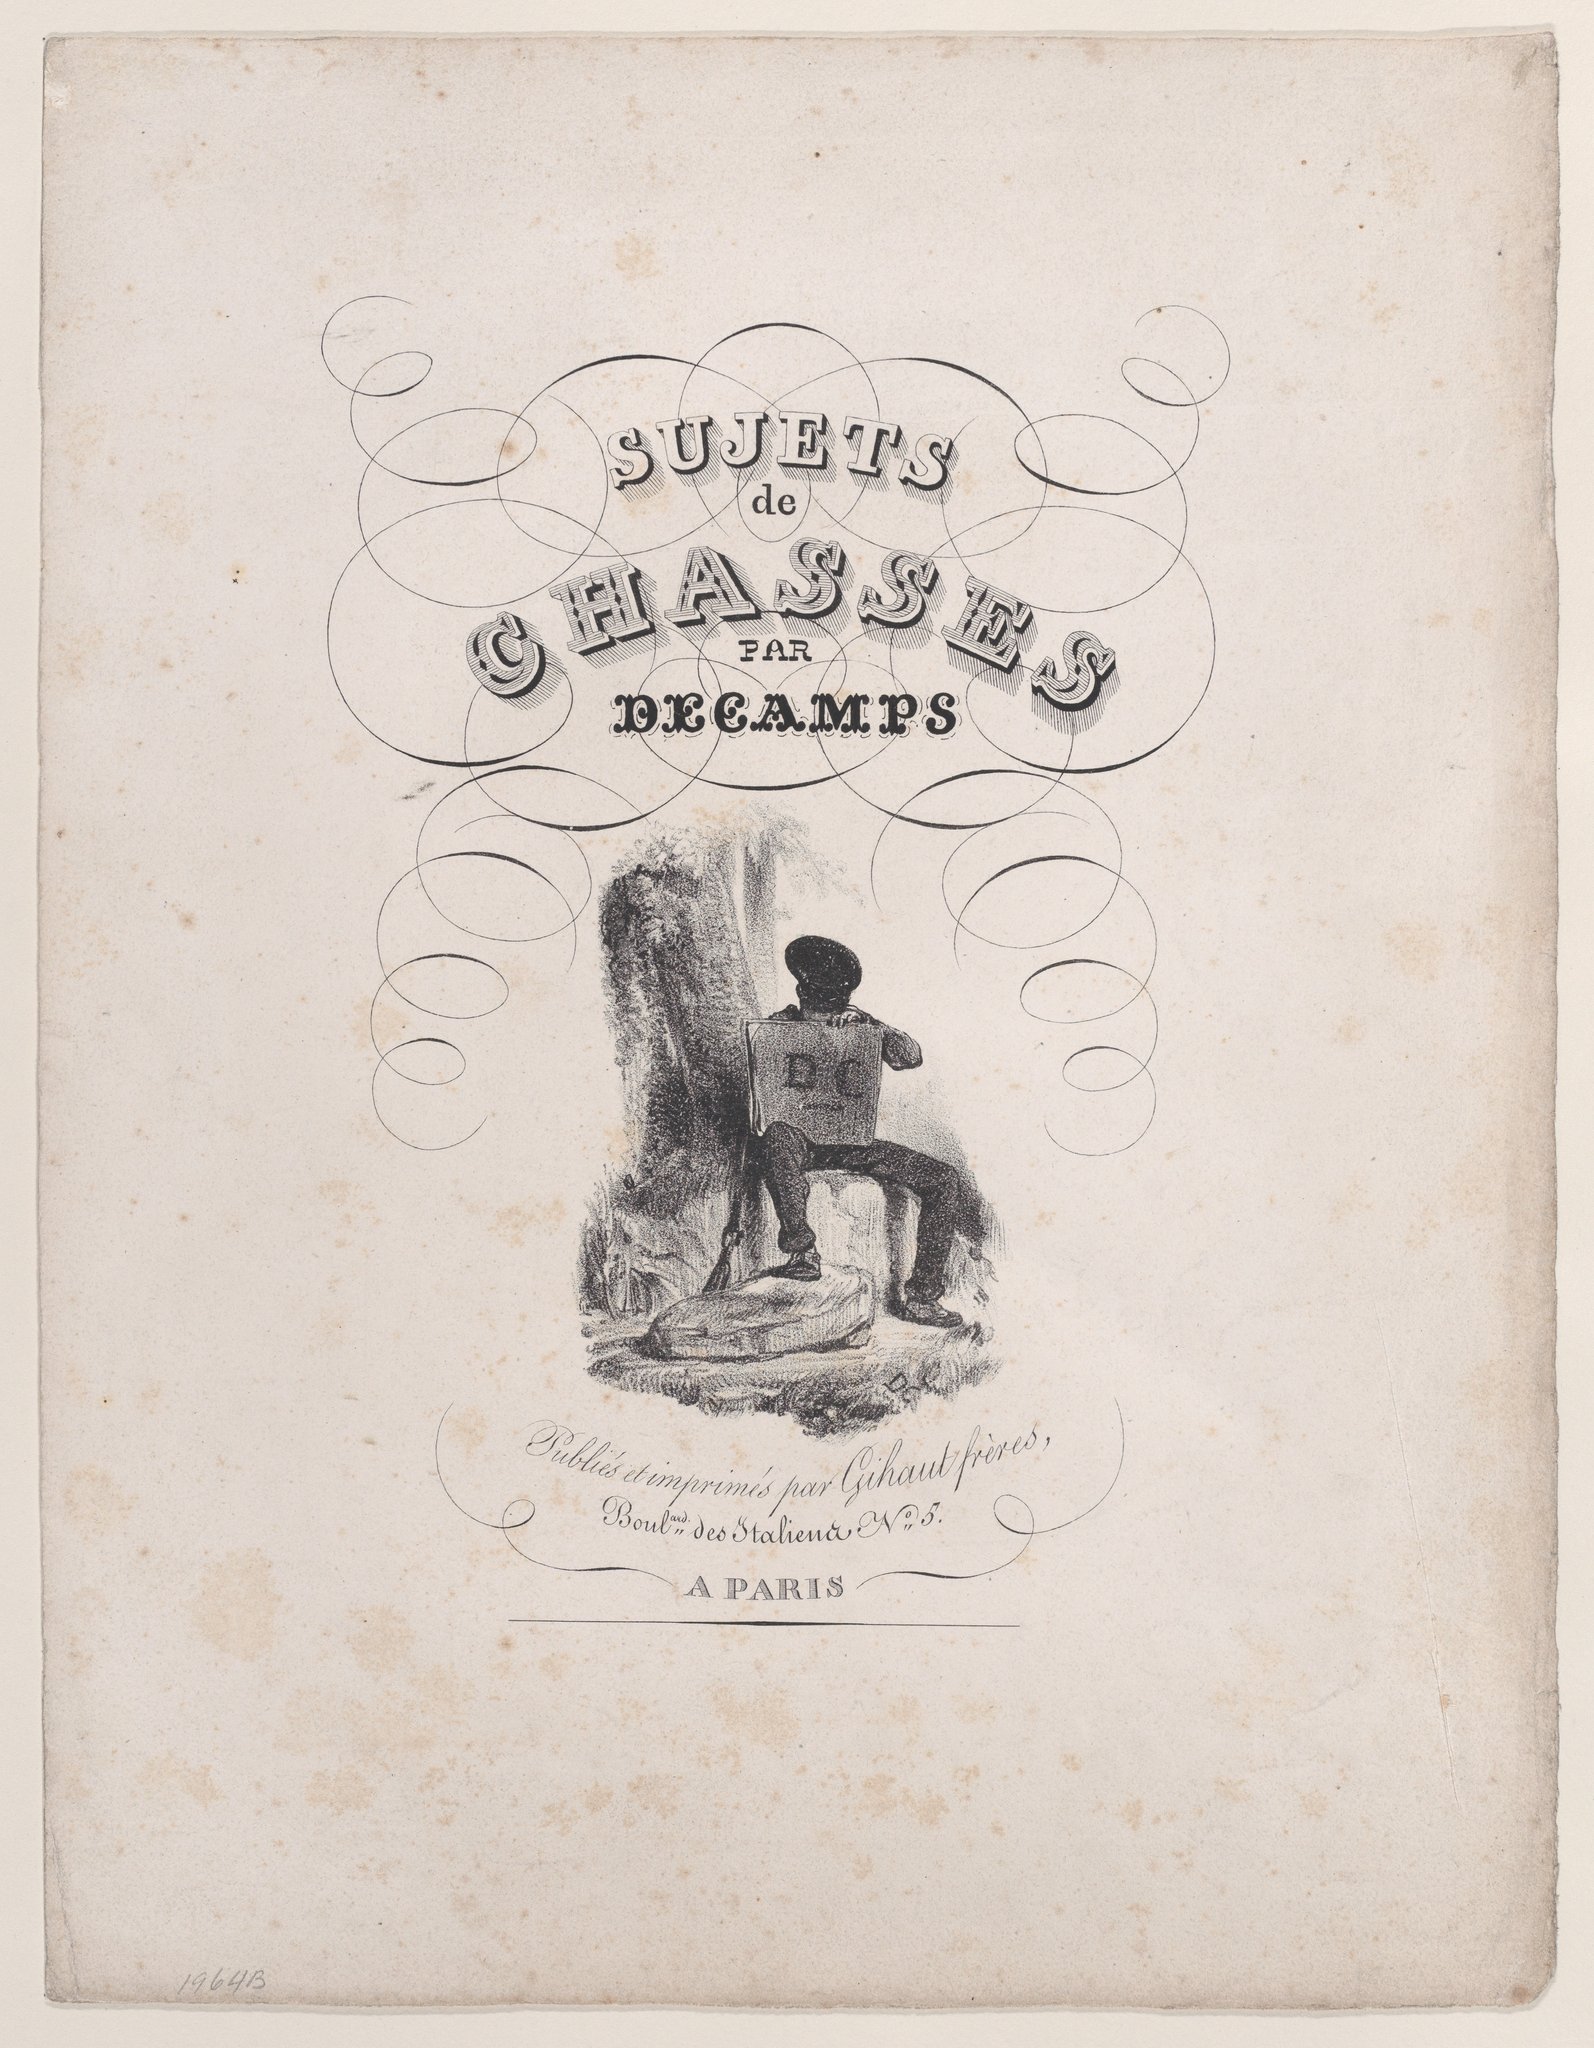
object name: print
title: Frontispiece, from "Hunting Scenes"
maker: alexandre-gabriel decamps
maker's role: artist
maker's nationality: french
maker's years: 1803-1860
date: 1829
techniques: lithograph